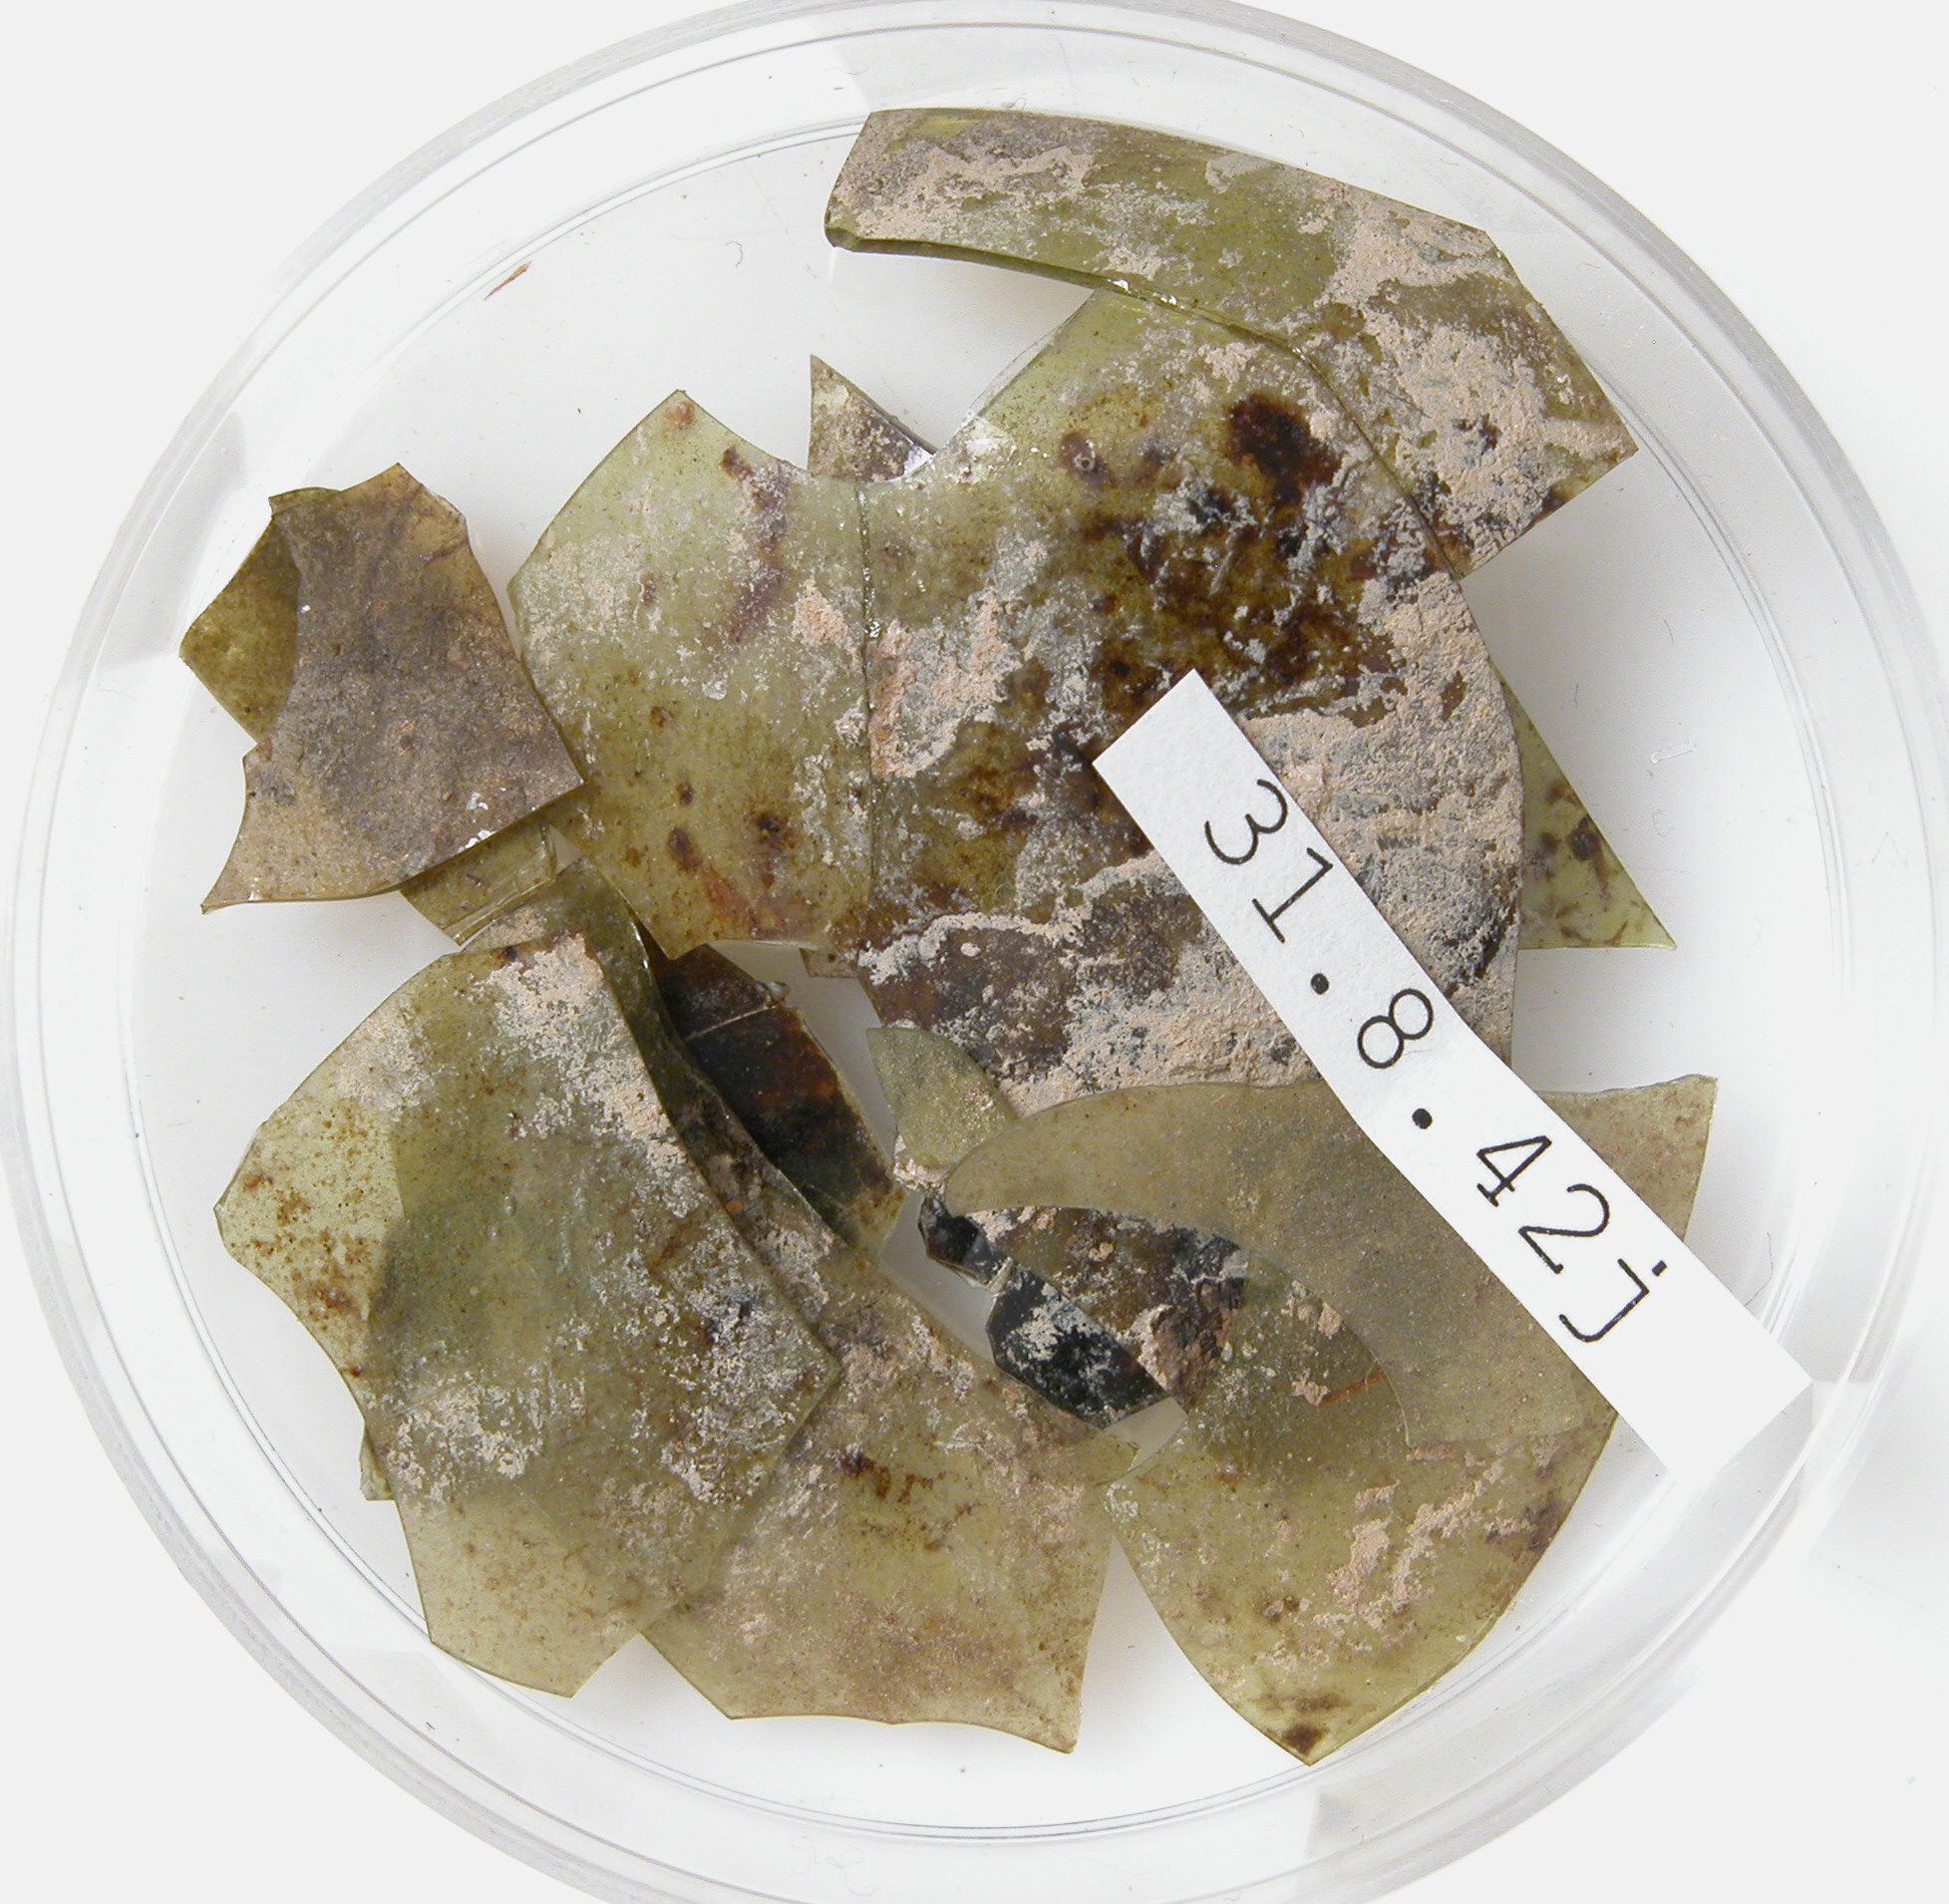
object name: fragment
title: Glass Fragments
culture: coptic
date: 301-400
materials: glass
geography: egypt